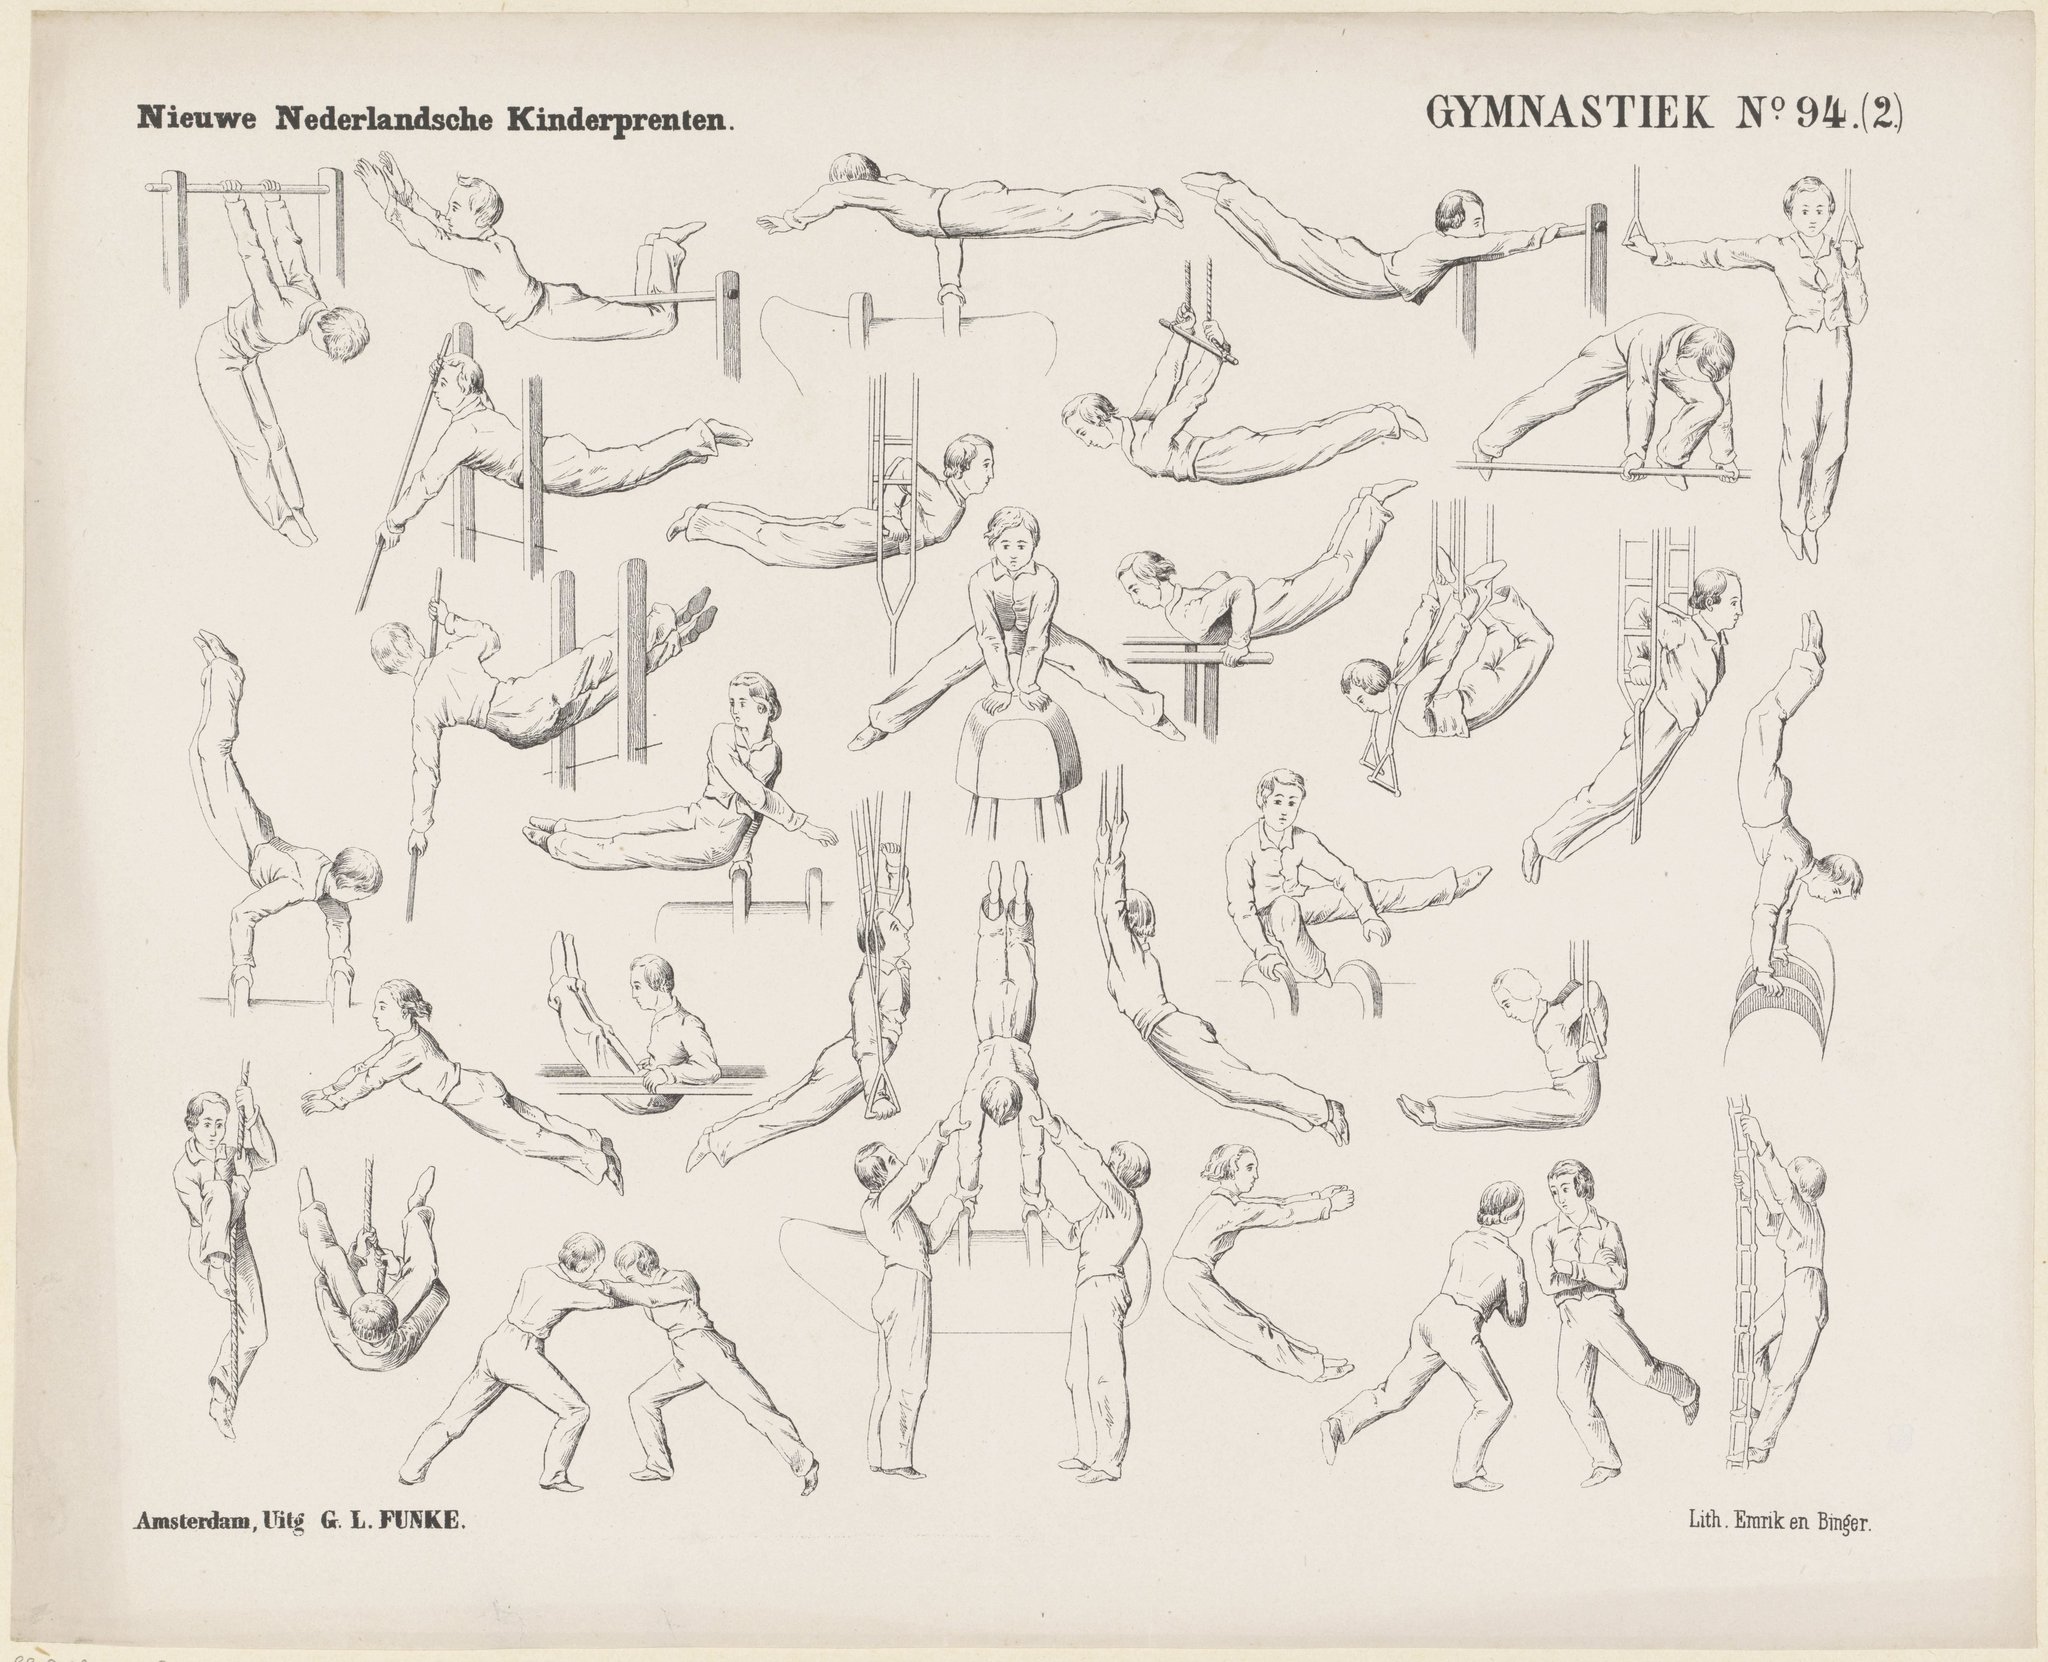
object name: print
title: Gymnastiek / (2)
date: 1865-1875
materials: paper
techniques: letterpress printing, lithograph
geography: haarlem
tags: vaulting horse (gymnastics), gymnastic exercises with apparatuses, parallel bars (gymnastics), rings (gymnastics), high-jumping (athletics, gymnastics), horizontal bar (gymnastics)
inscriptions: collector's mark: Lugt 2760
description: Blad met 30 voorstellingen van jongens die sport- en gymnastiekoefeningen demonstreren. Genummerd rechtsboven: No. 94.